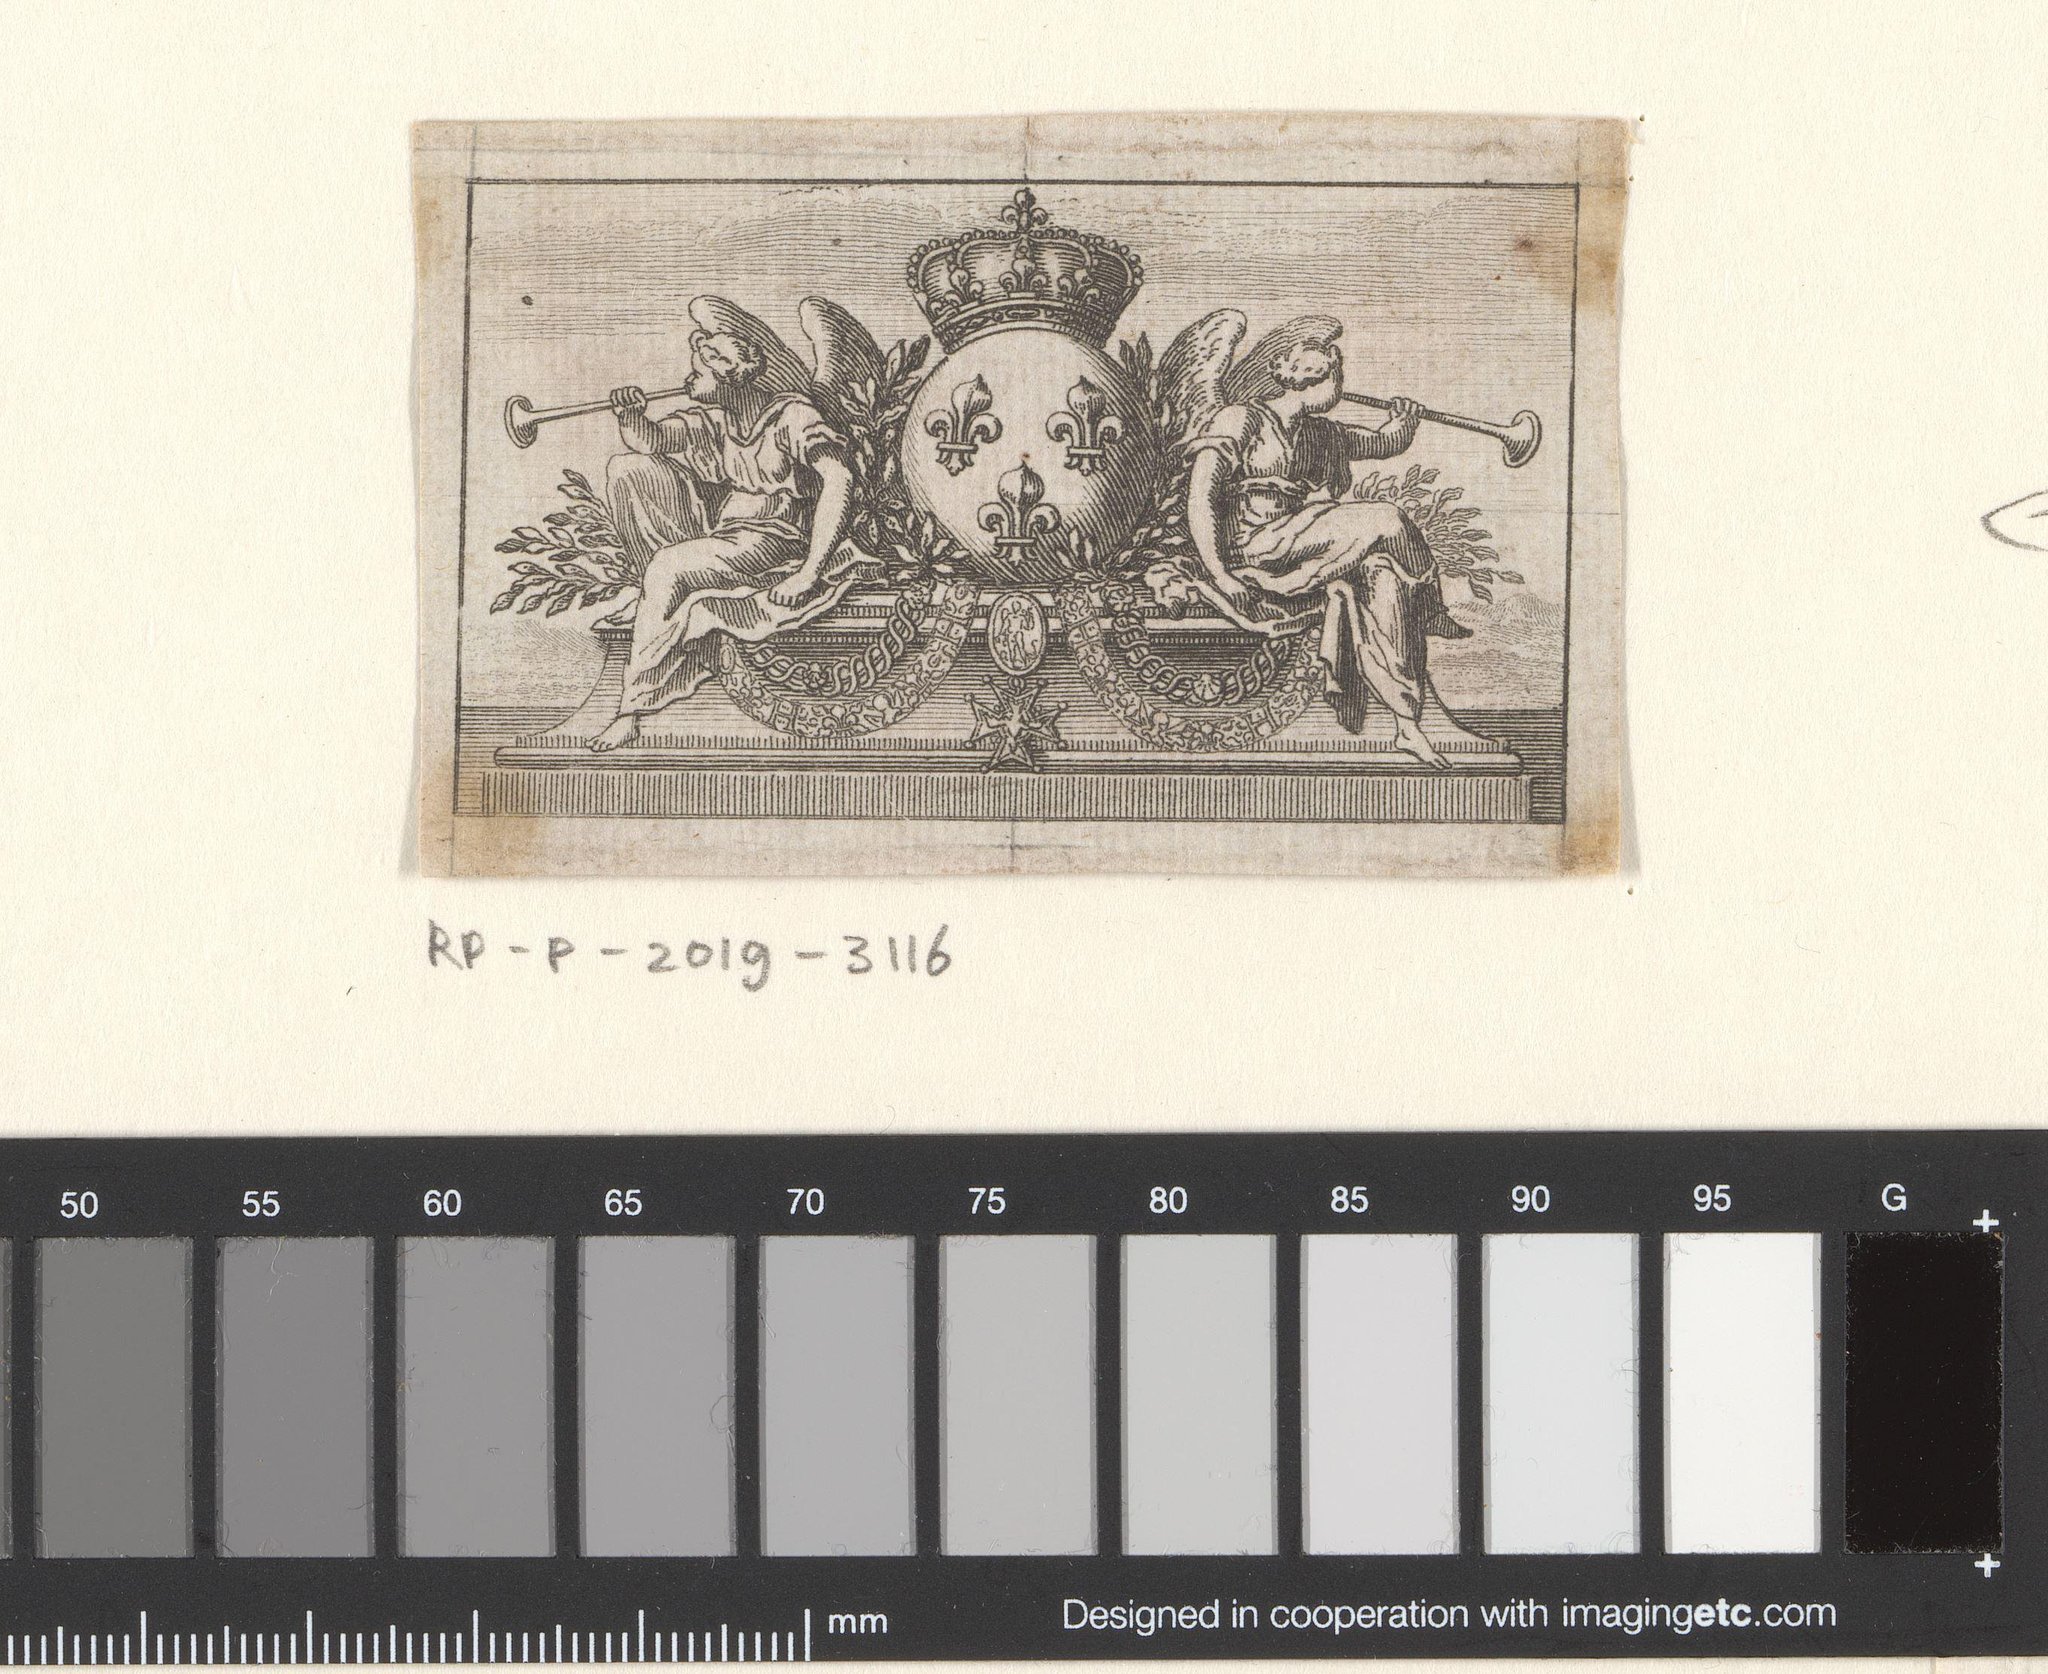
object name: vignette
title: Vignet met een schild met drie Franse lelies geflankeerd door twee engelen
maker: Anonymous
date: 1650-1750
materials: paper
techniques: etching, letterpress printing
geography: france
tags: angels singing, making music, illustration ~ printed matter, book, insignia and symbols of sovereignty (crown, diadem, sceptre, orb, seal, standard, cloak, pectoral)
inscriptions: collector's mark: Lugt 2228